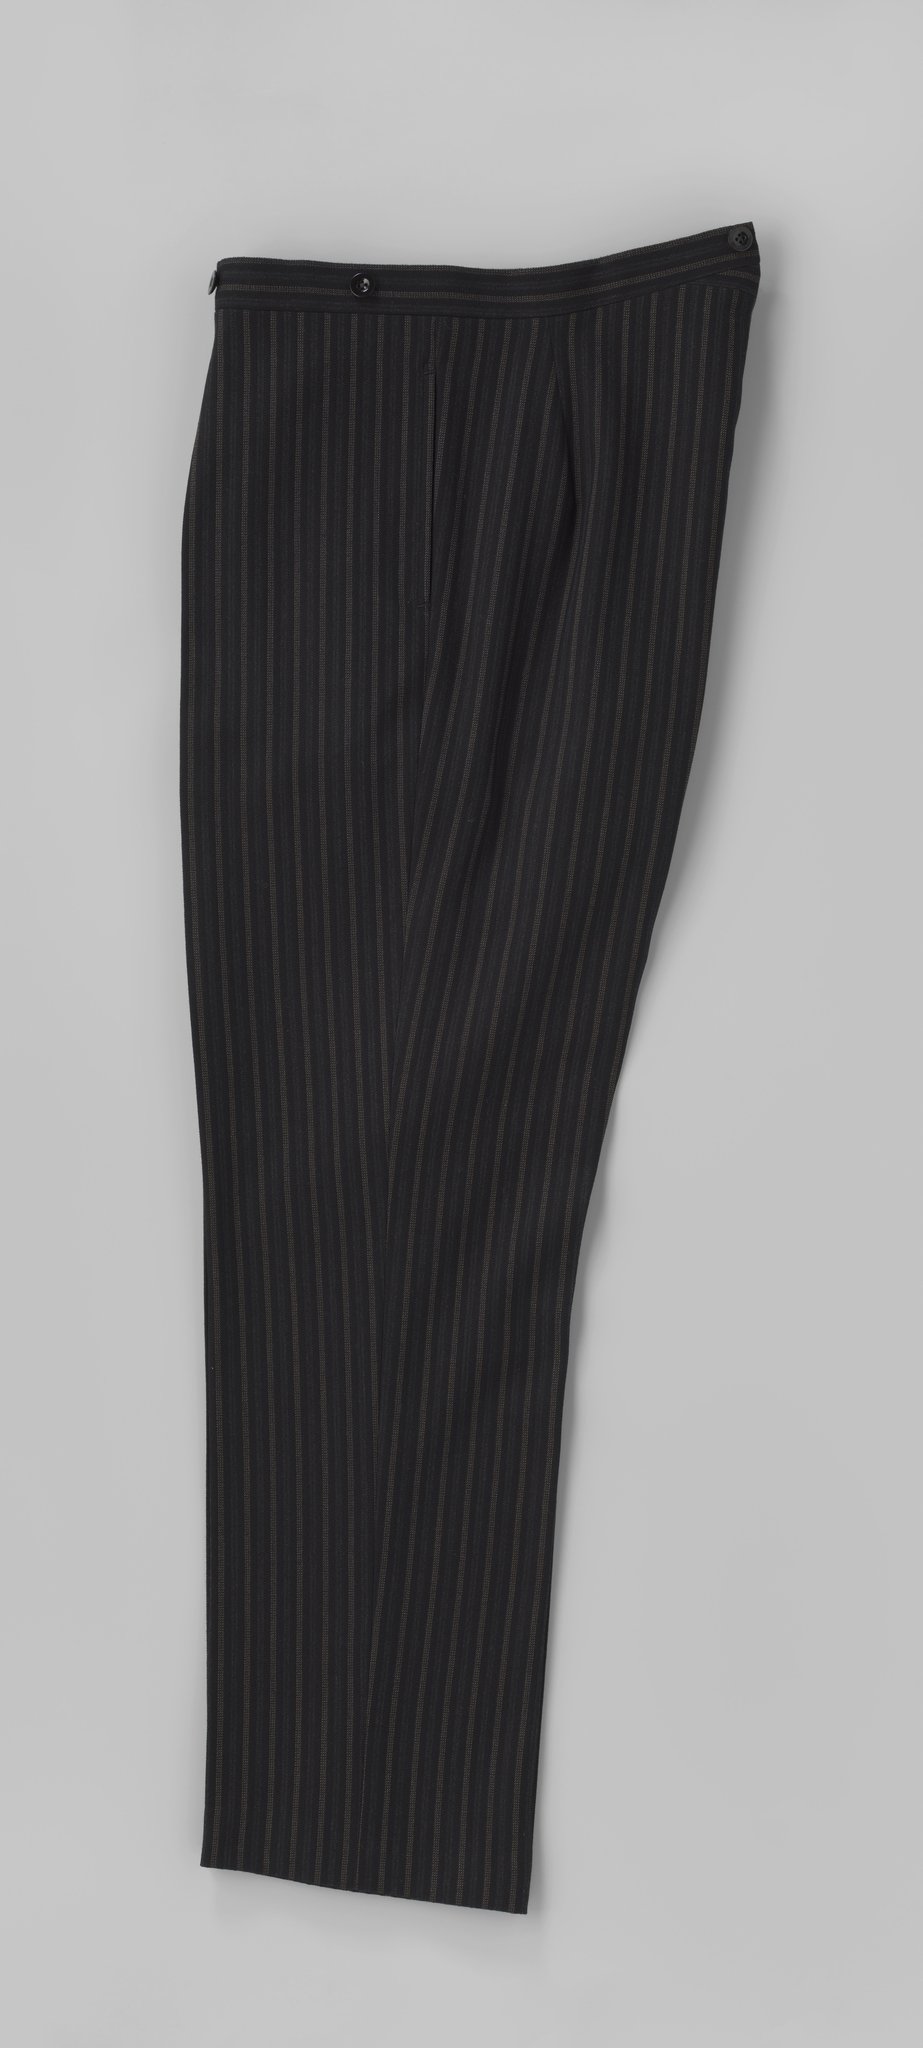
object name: main garment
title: Lange broek van grijs gestreepte zwarte wol, met rechte pijpen zonder omslag, ingeperste pli, drie zakken, knoopsluiting en tailleband met zes knopen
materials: wool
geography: the hague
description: Broek van grijs gestreepte wol, onderdeel van jacquet. Broek met rechte pijpen zonder omslag, met ingeperste pli. Glad boord met zes knopen voor bretel. Drie zakken. Knoopsluiting.